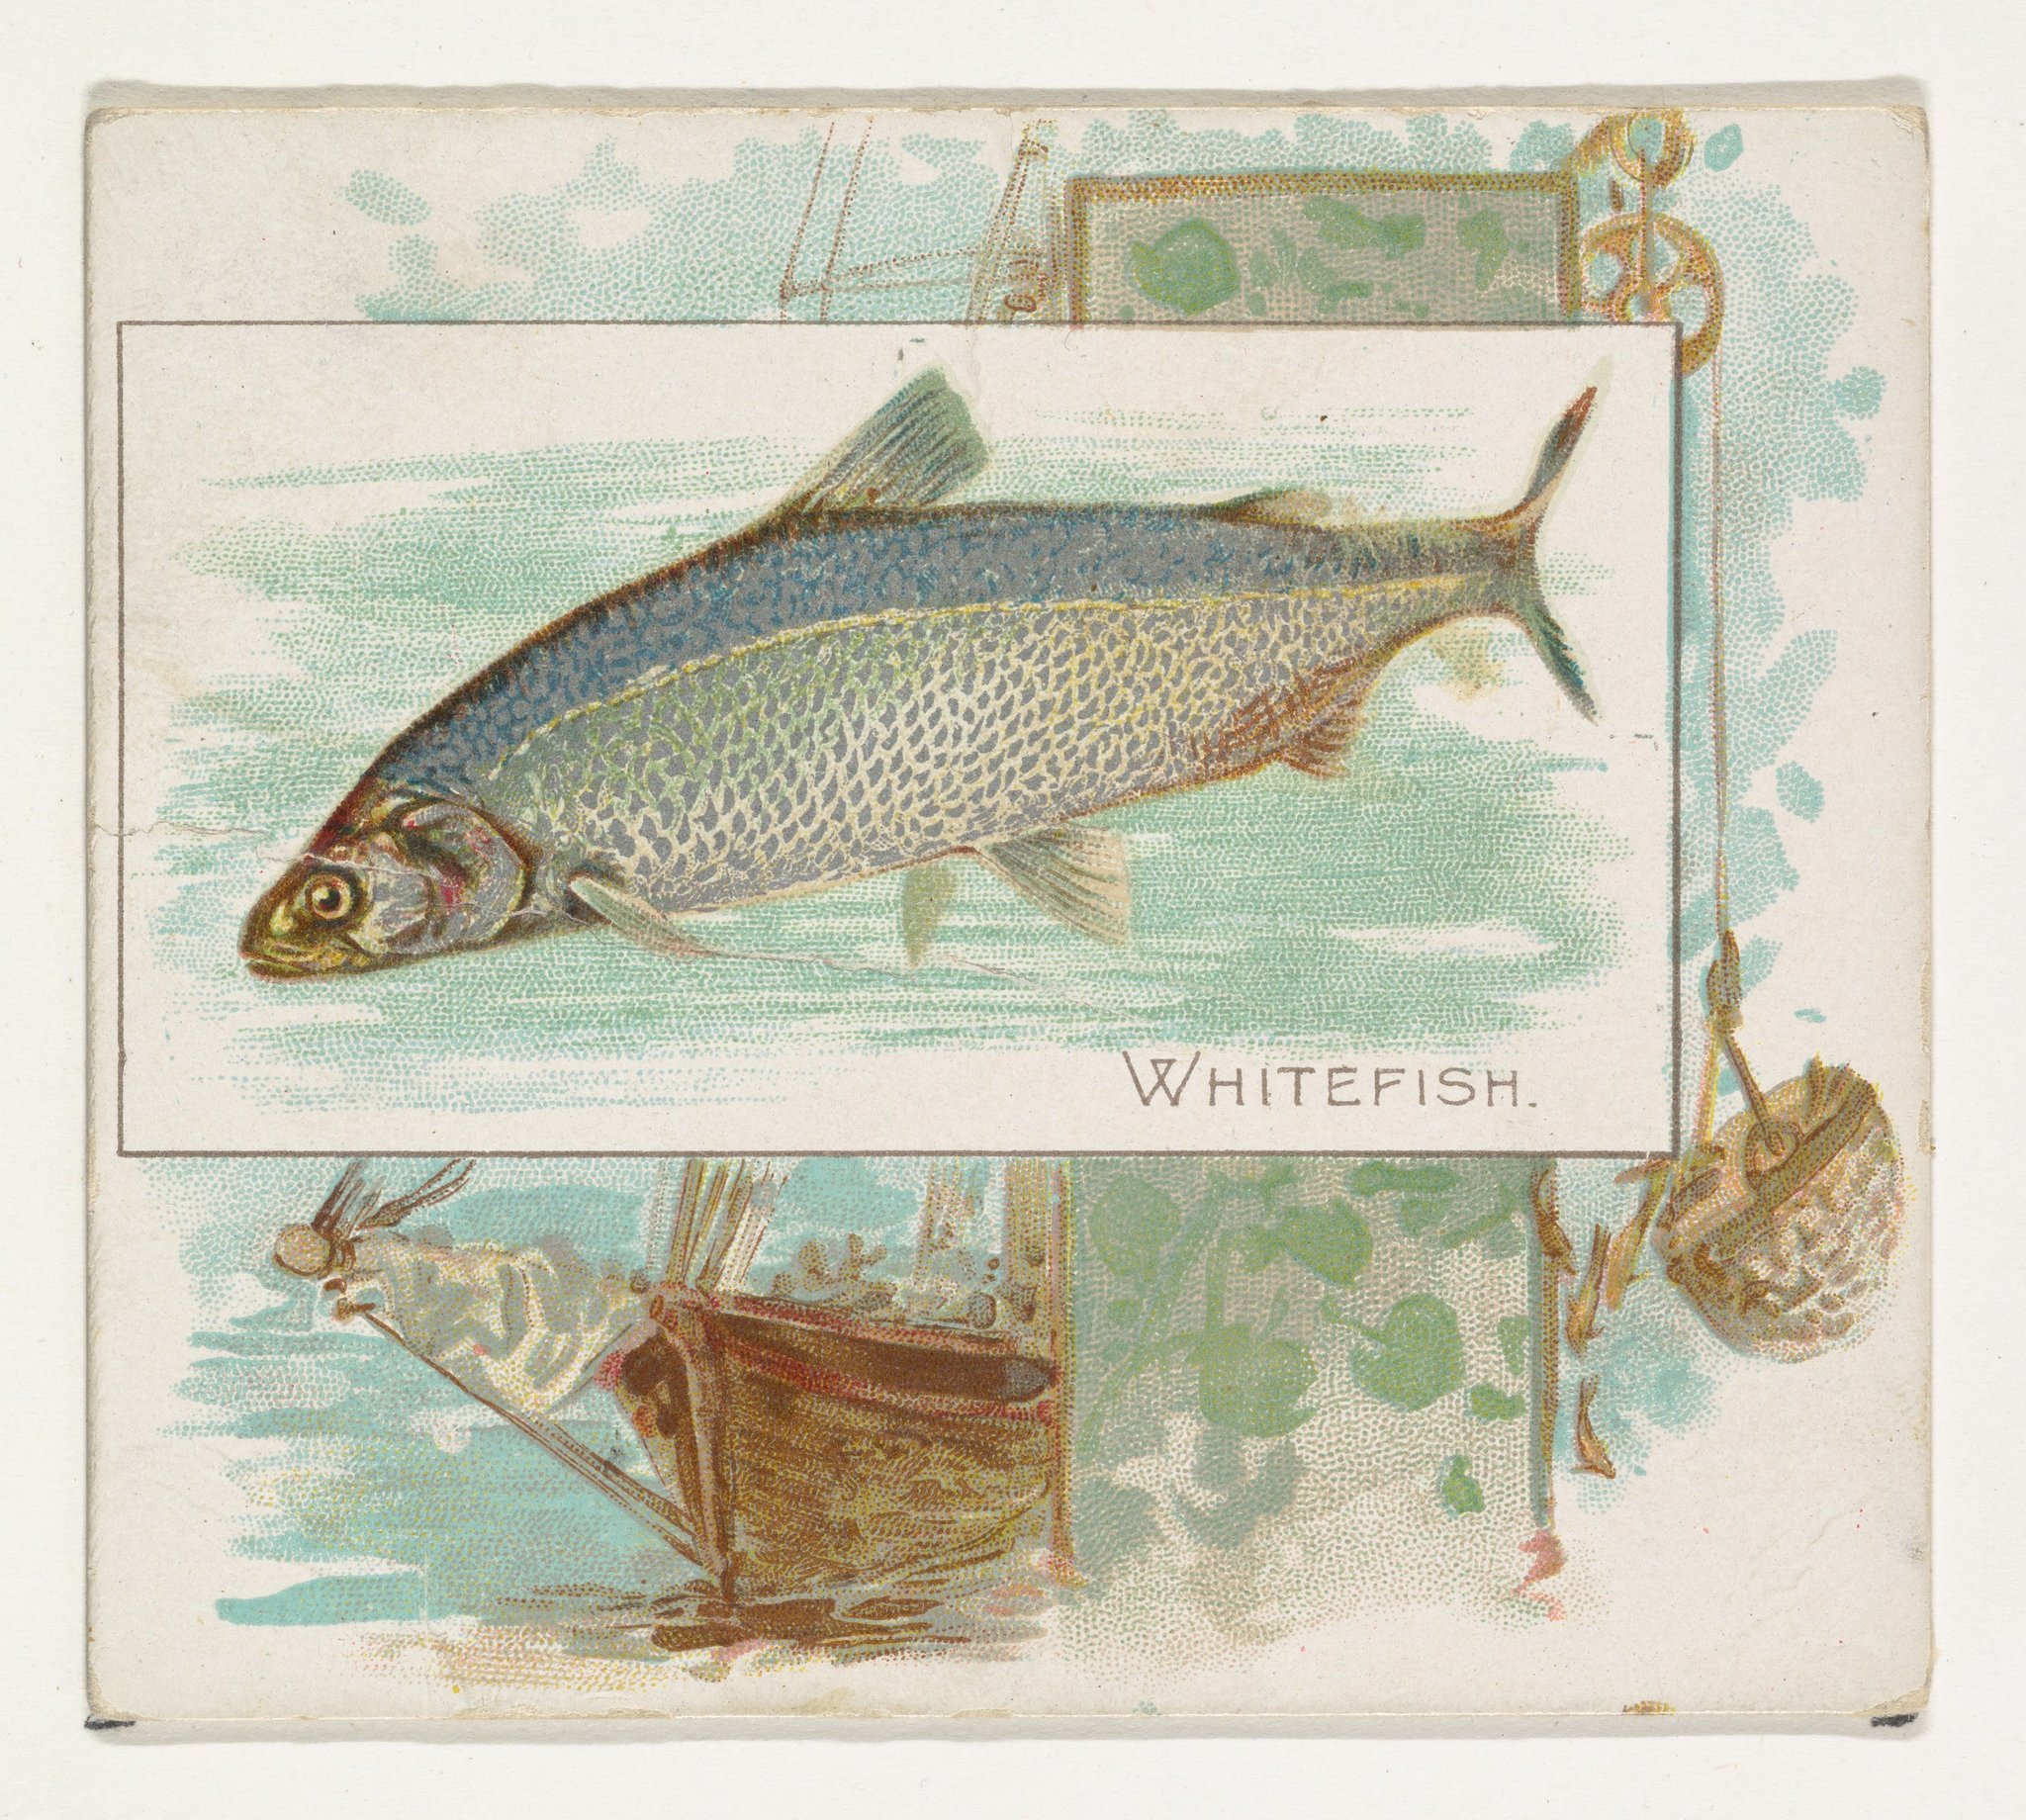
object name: print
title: Whitefish, from Fish from American Waters series (N39) for Allen & Ginter Cigarettes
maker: allen & ginter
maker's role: publisher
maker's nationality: american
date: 1889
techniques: color lithograph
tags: fish